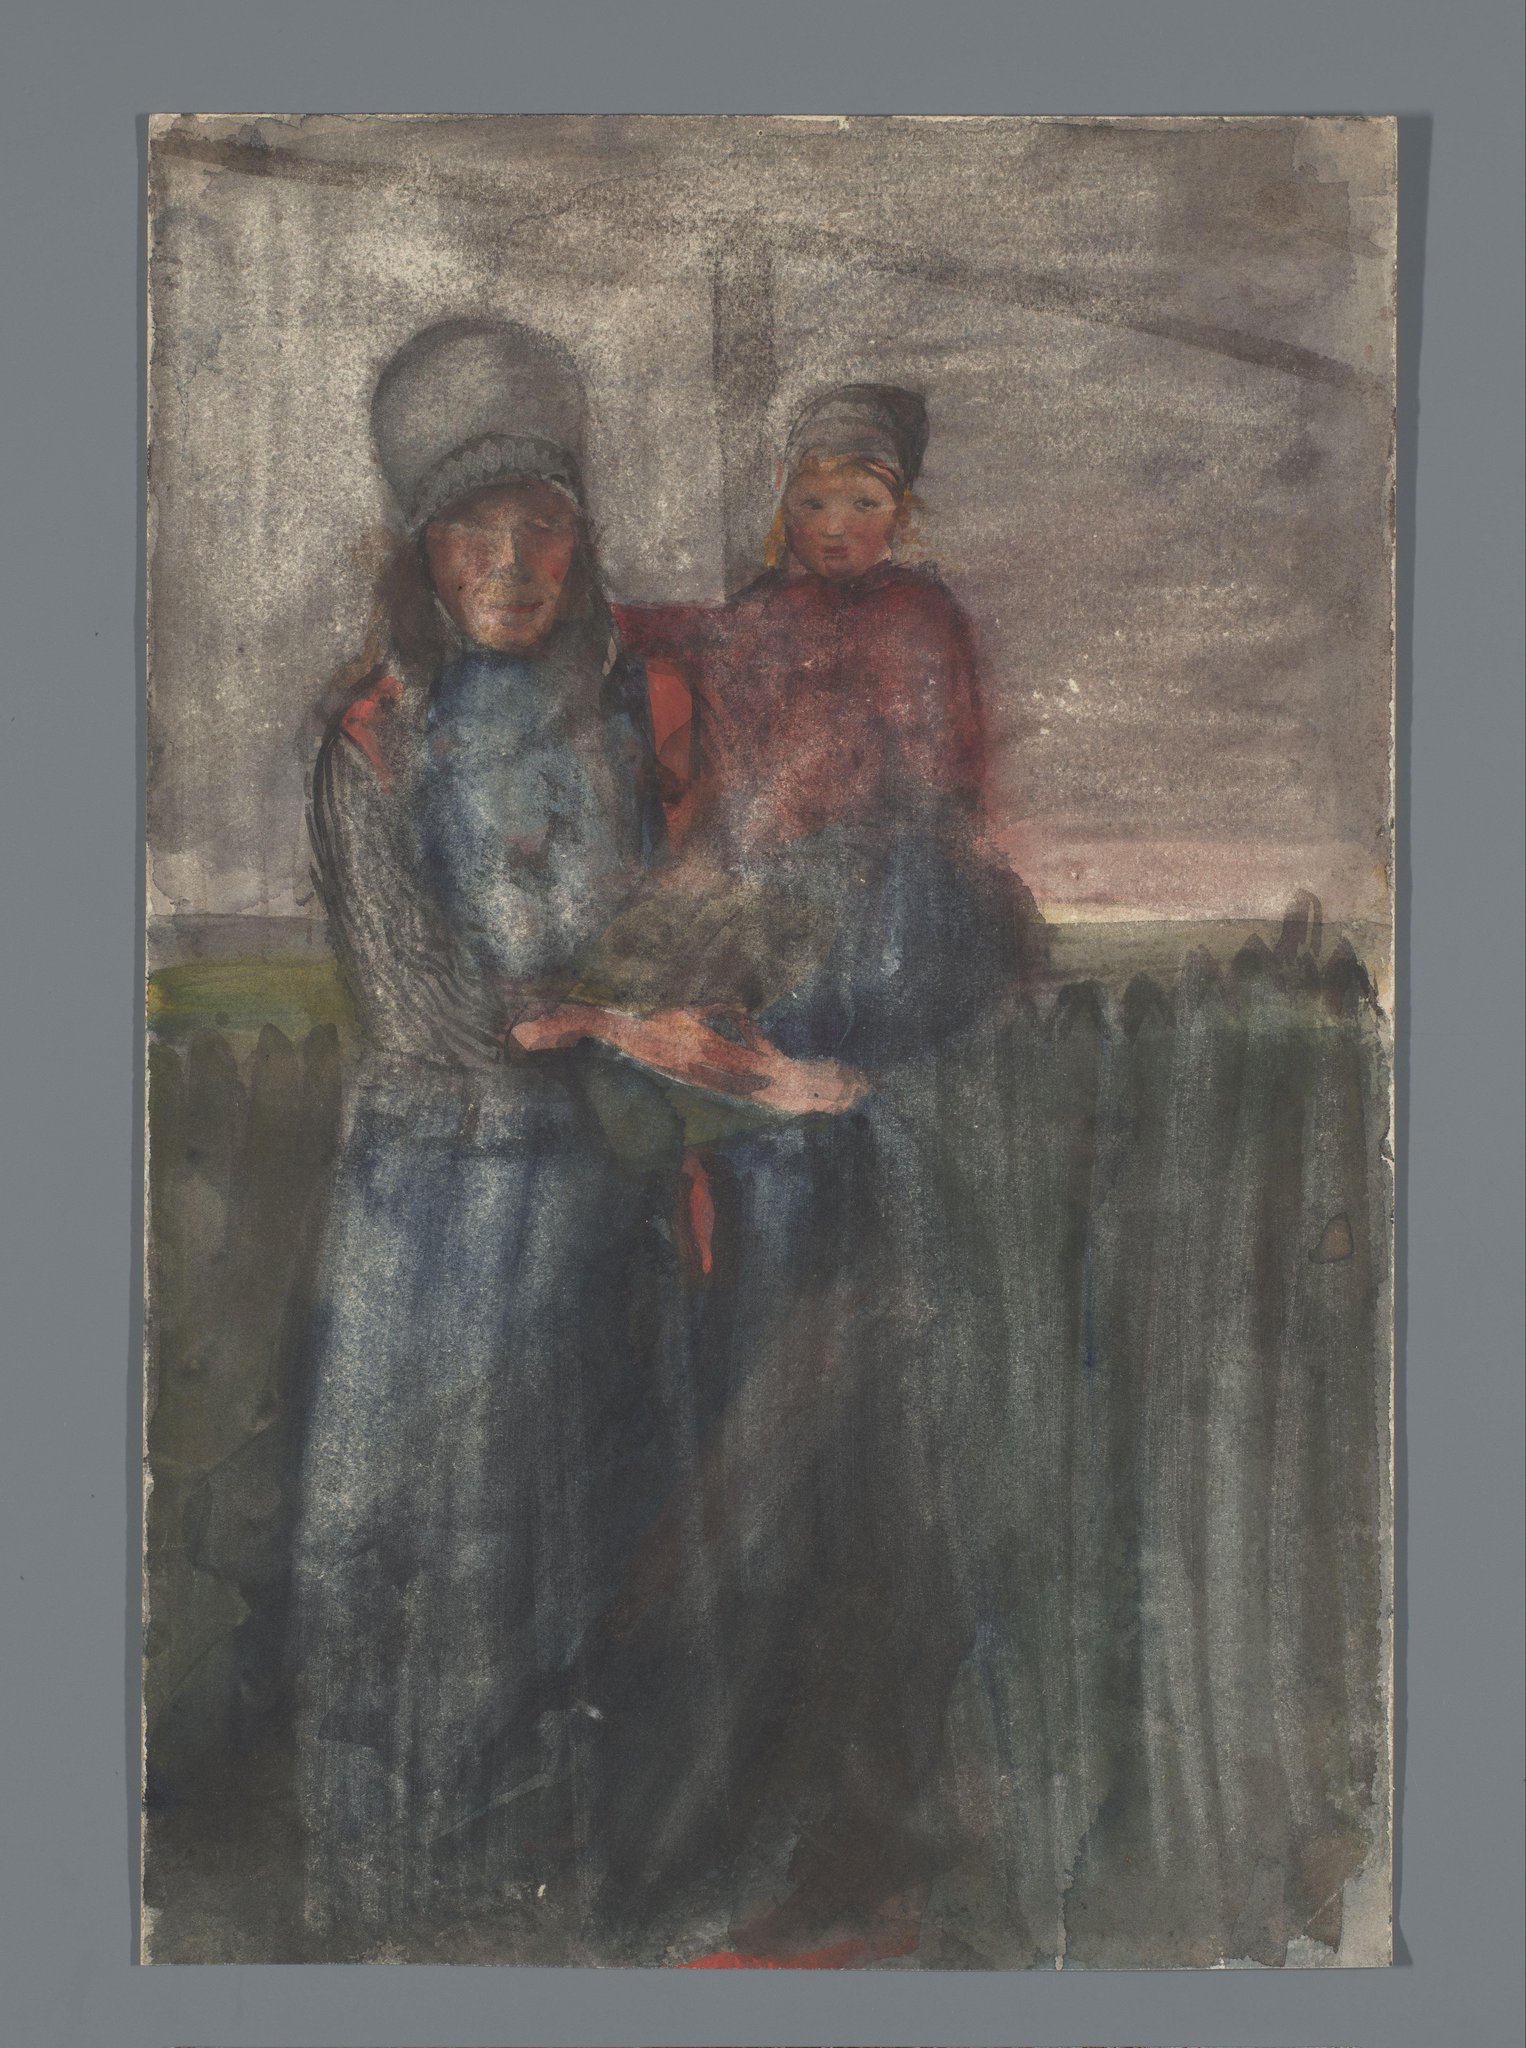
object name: drawing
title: Markense vrouw met kind op de arm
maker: carel adolph lion cachet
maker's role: draughtsman, print maker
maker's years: 1864-1945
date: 1874-1945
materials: paper, watercolor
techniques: brush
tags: mother and baby or young child, folk costume, regional costume